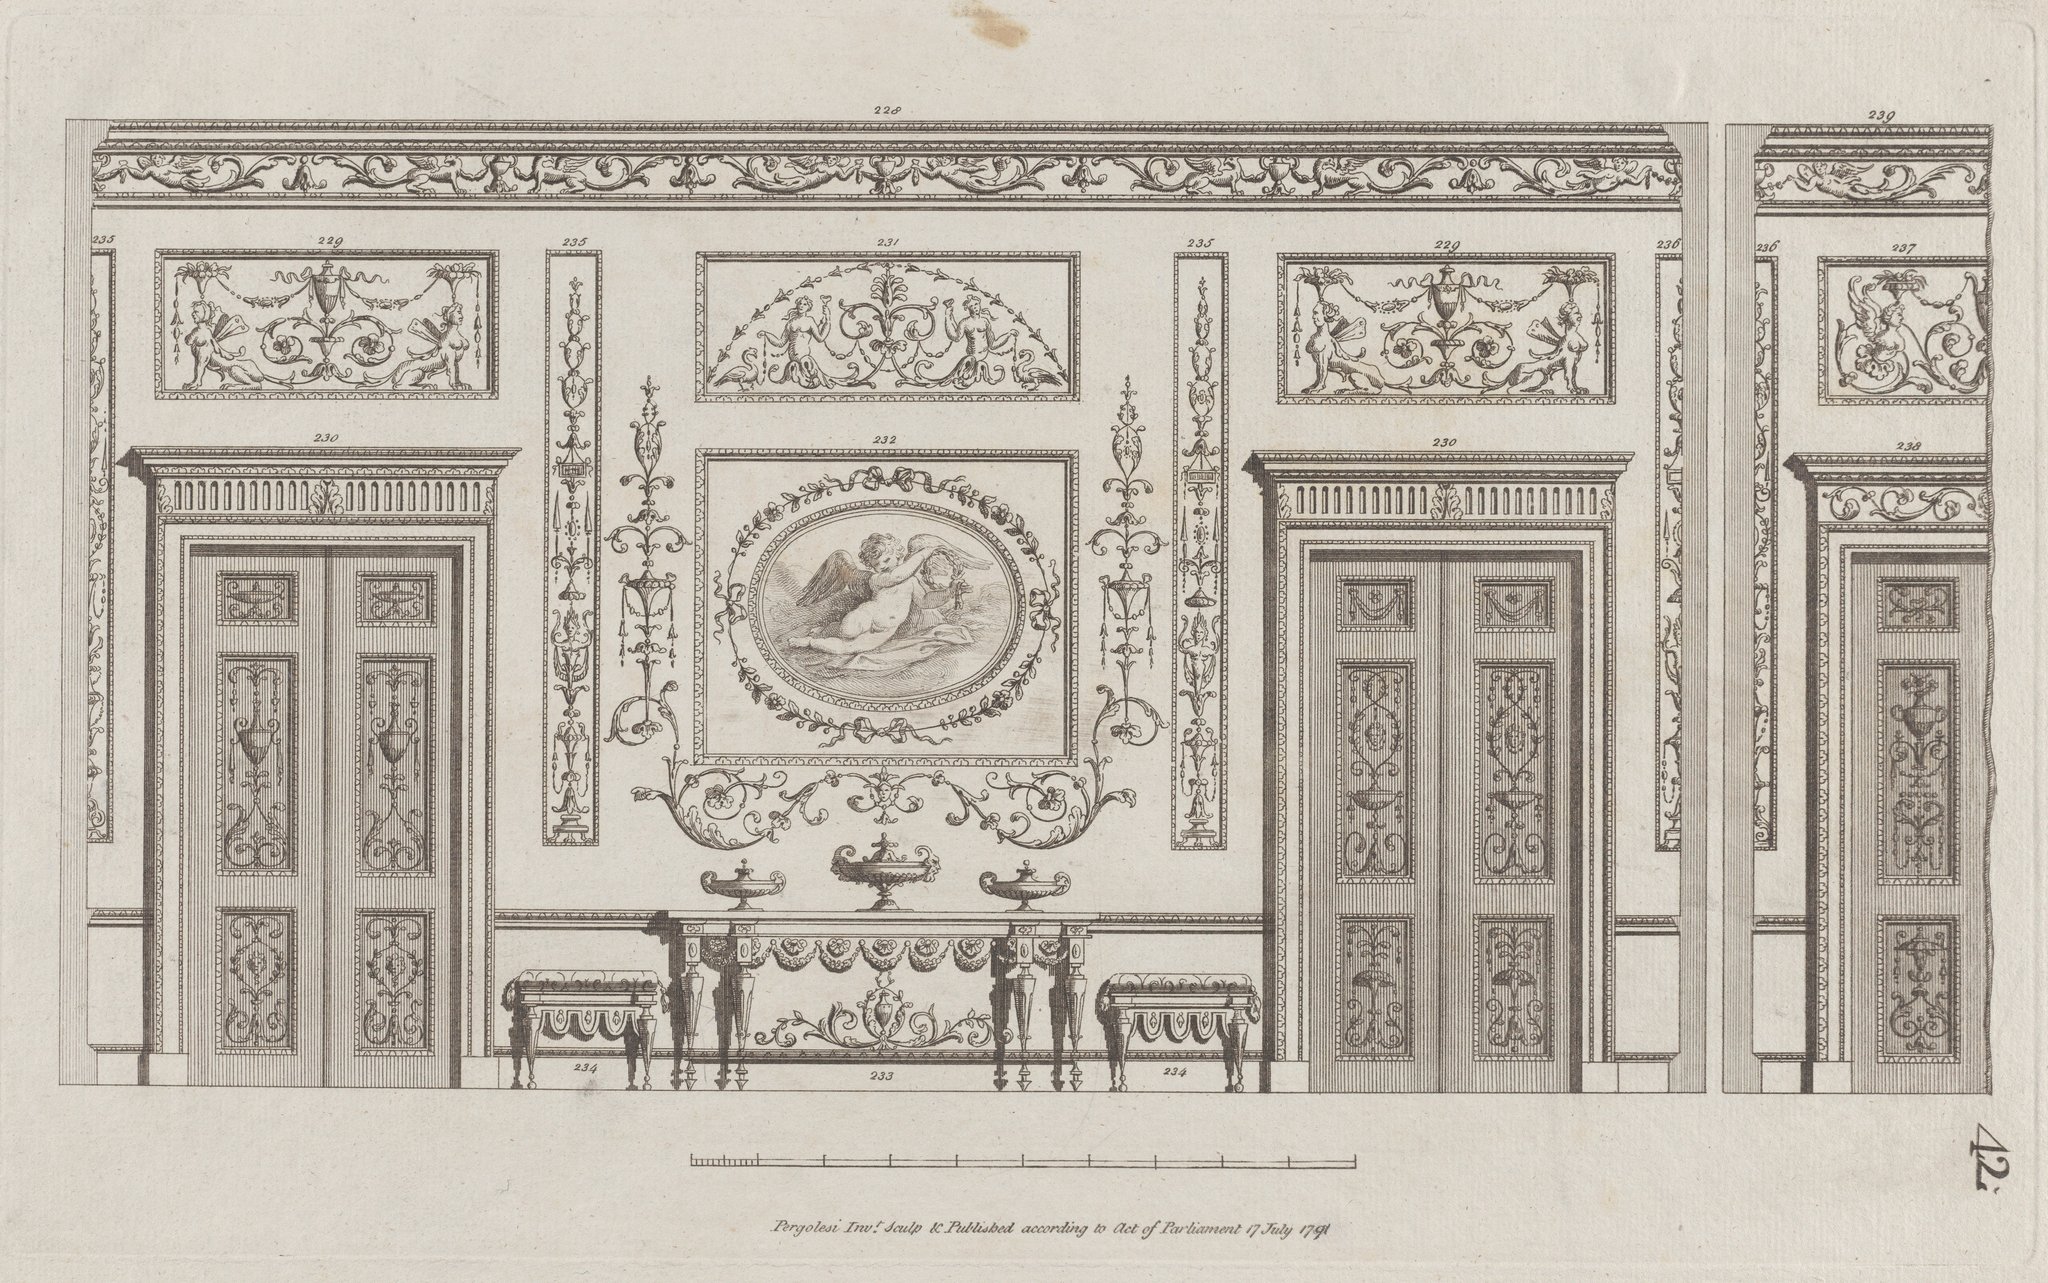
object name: print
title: Interior Ornamented Wall with Doors, nos. 228–239, plate 42 from "Designs for Various Ornaments"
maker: michelangelo pergolesi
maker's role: artist and publisher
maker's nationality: italian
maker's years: 1760-1801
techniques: etching